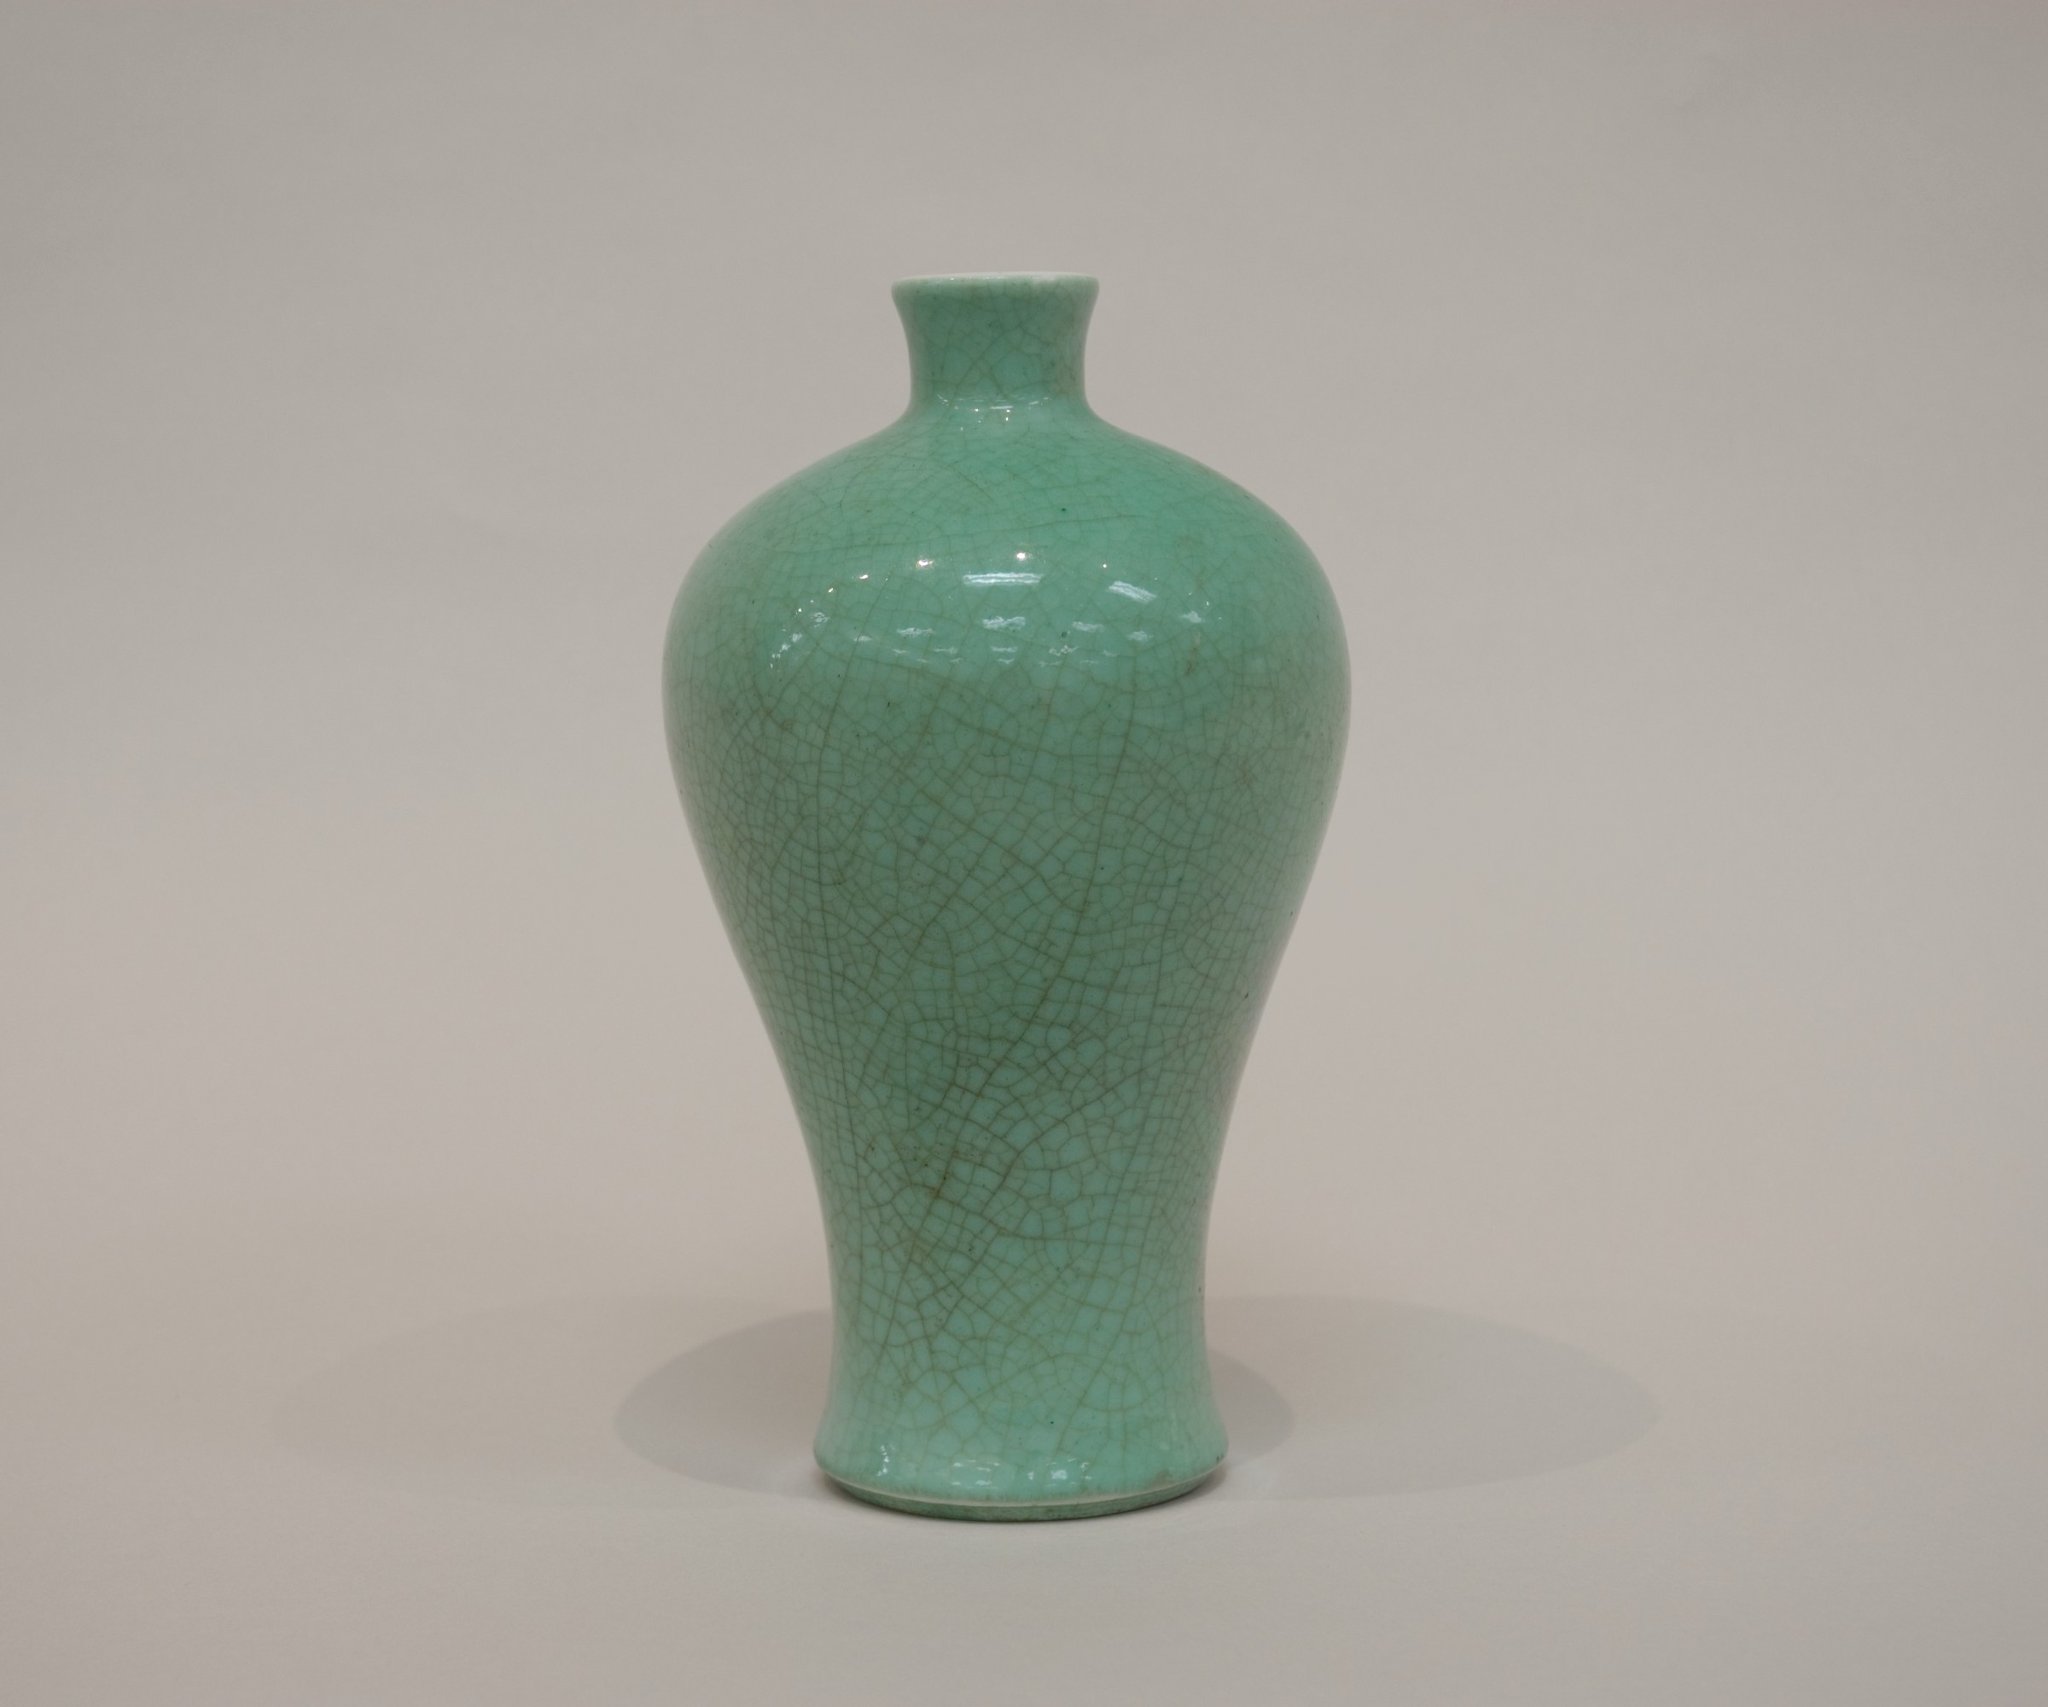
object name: vase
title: Meiping vase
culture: chinese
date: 1701-1733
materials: glaze, porcelain